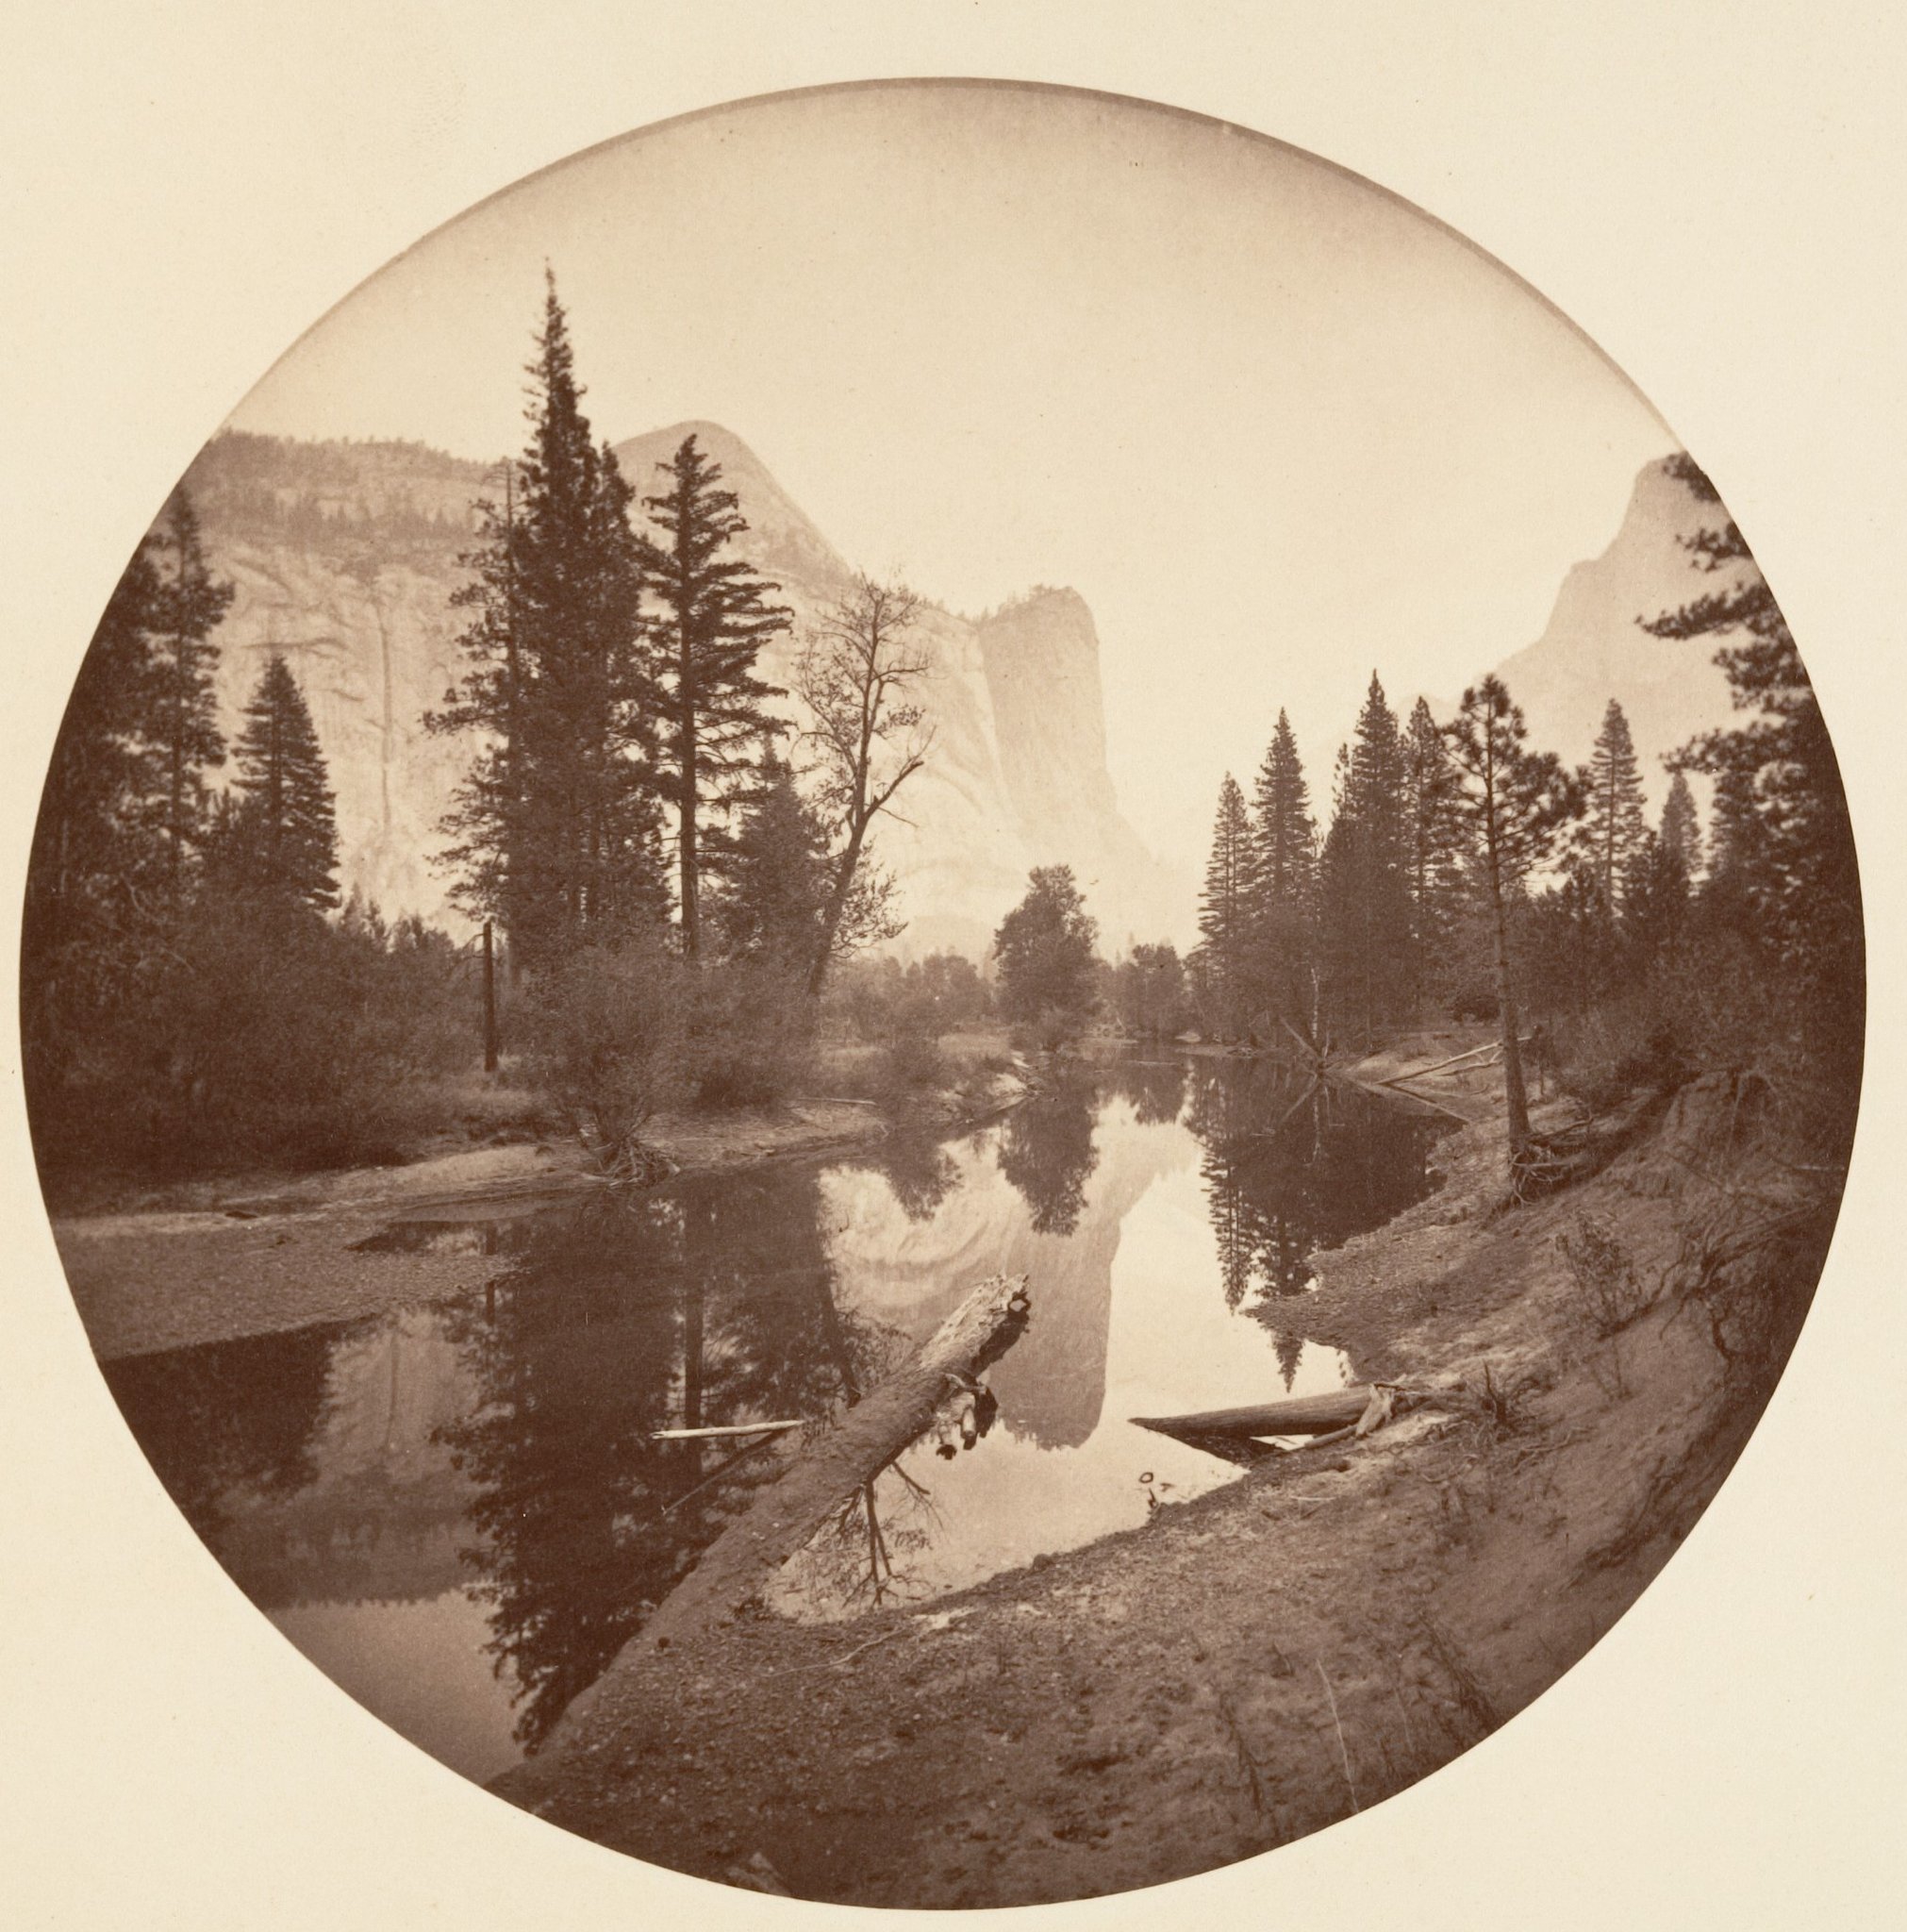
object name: photograph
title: [Yosemite National Park, California]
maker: carleton e. watkins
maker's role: artist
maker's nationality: american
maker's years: 1829-1916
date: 1878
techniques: albumen silver print, glass negative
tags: rivers,forests,landscapes